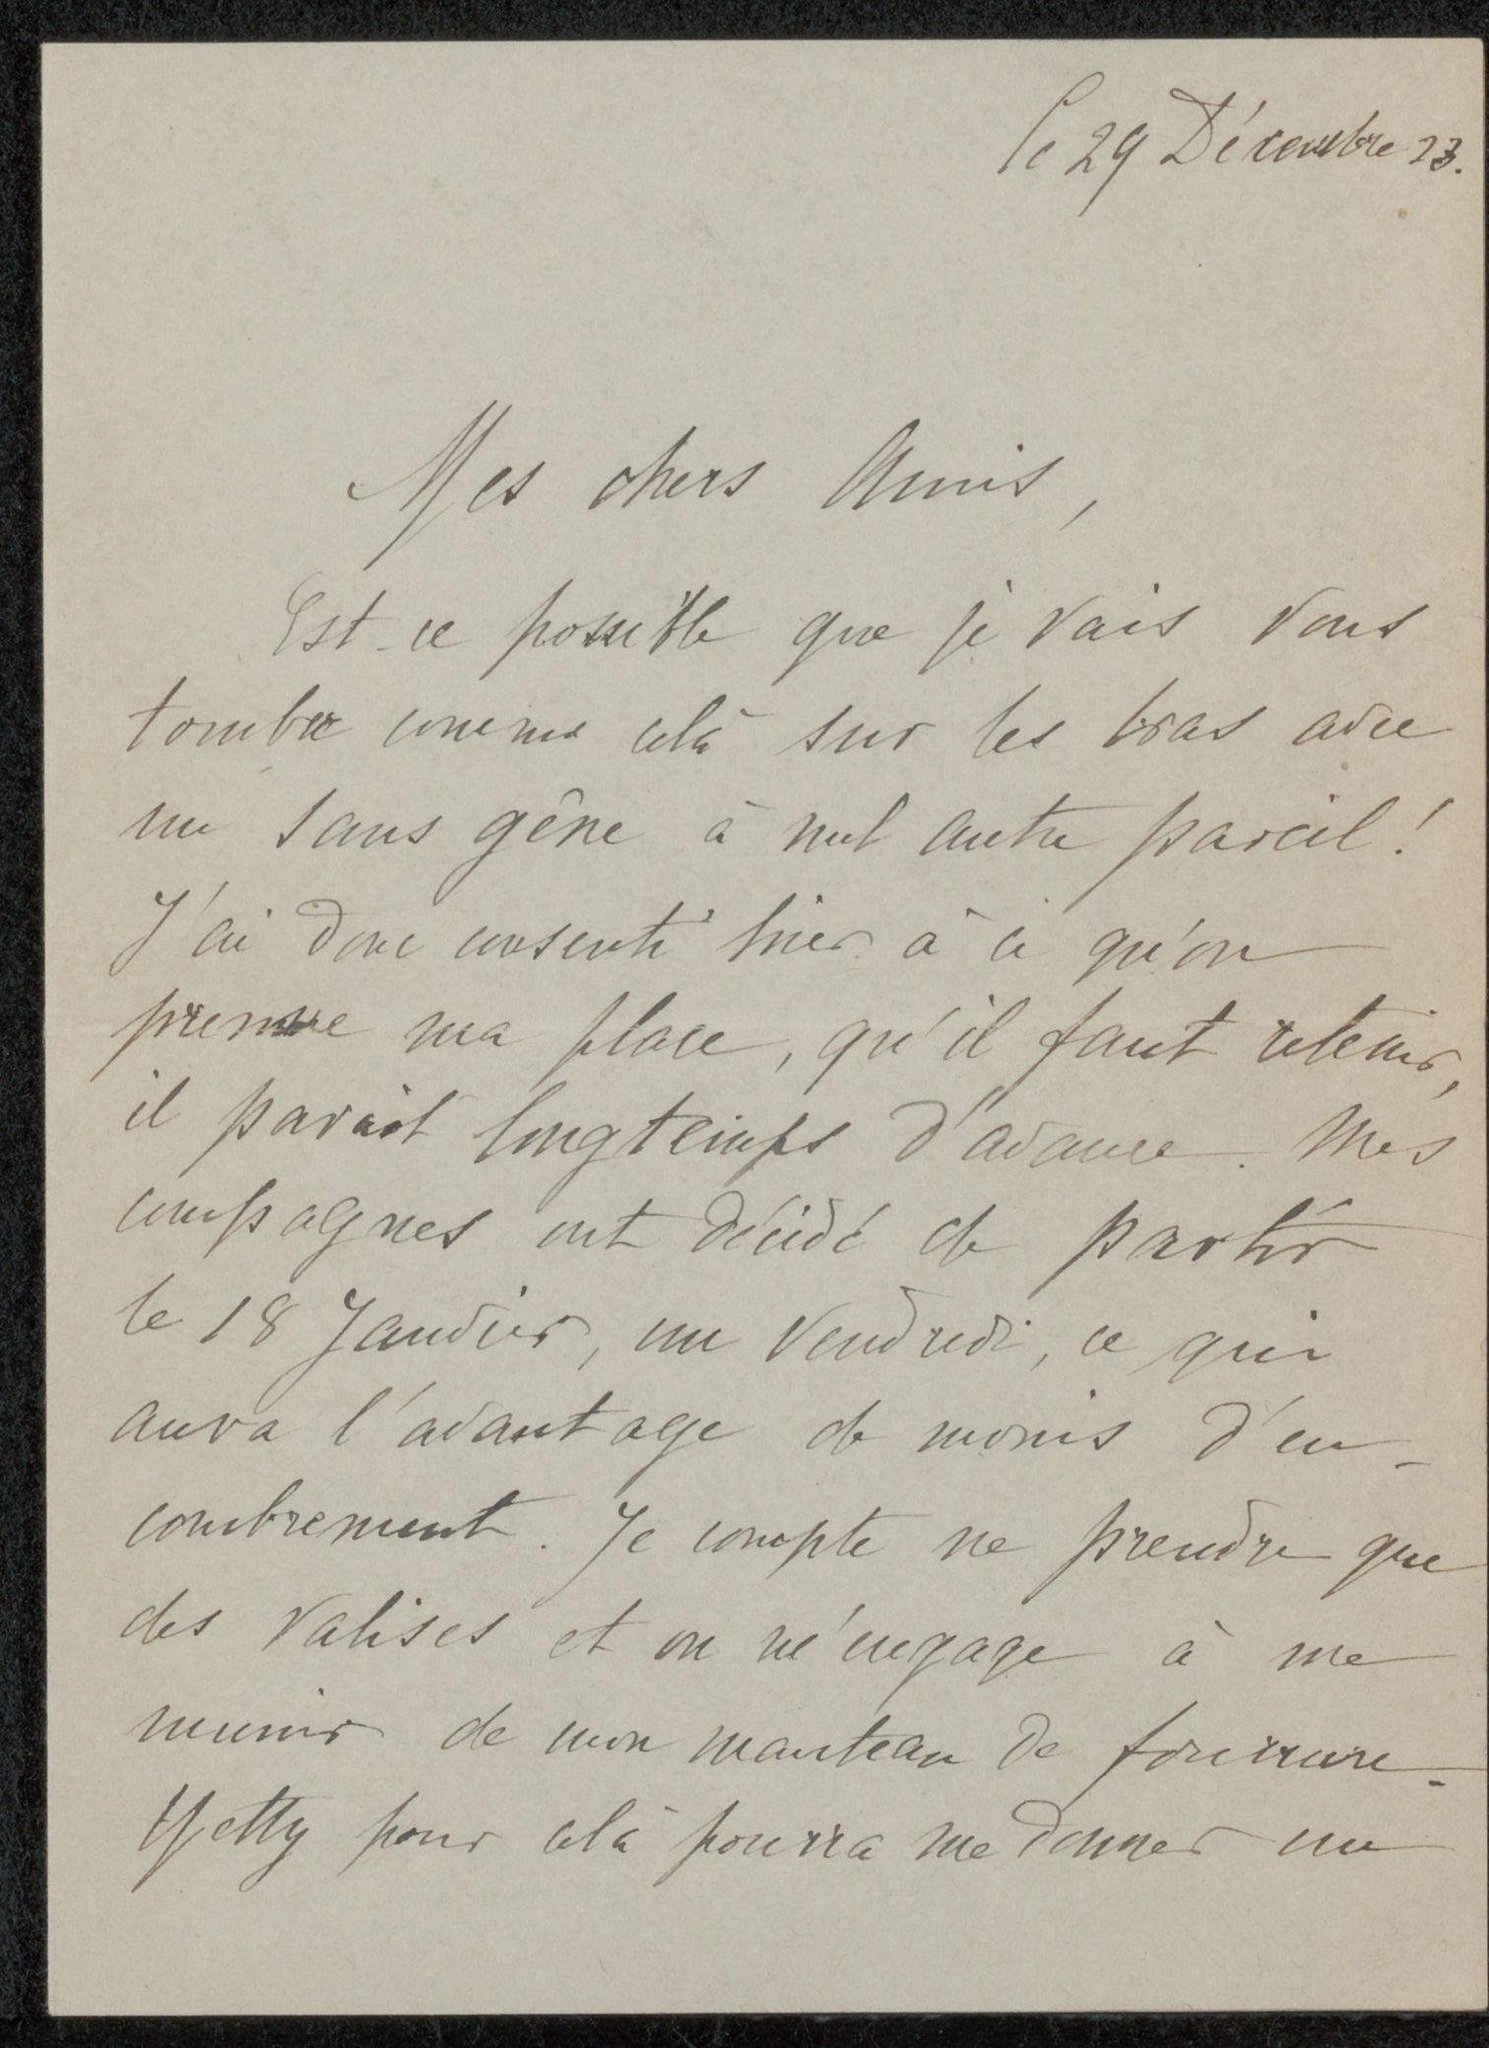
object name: letter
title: Brief aan Philip Zilcken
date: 1923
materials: ink, paper, pencil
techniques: pen, writing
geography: brussels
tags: jeanne boels de buck, the hague, painter, draughtsman, philip zilcken, vase ~ ornament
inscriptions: collector's mark: ‘RPK’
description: Brief bevat conceptbrief van Philip Zilcken aan Jeanne Boels de Buck.